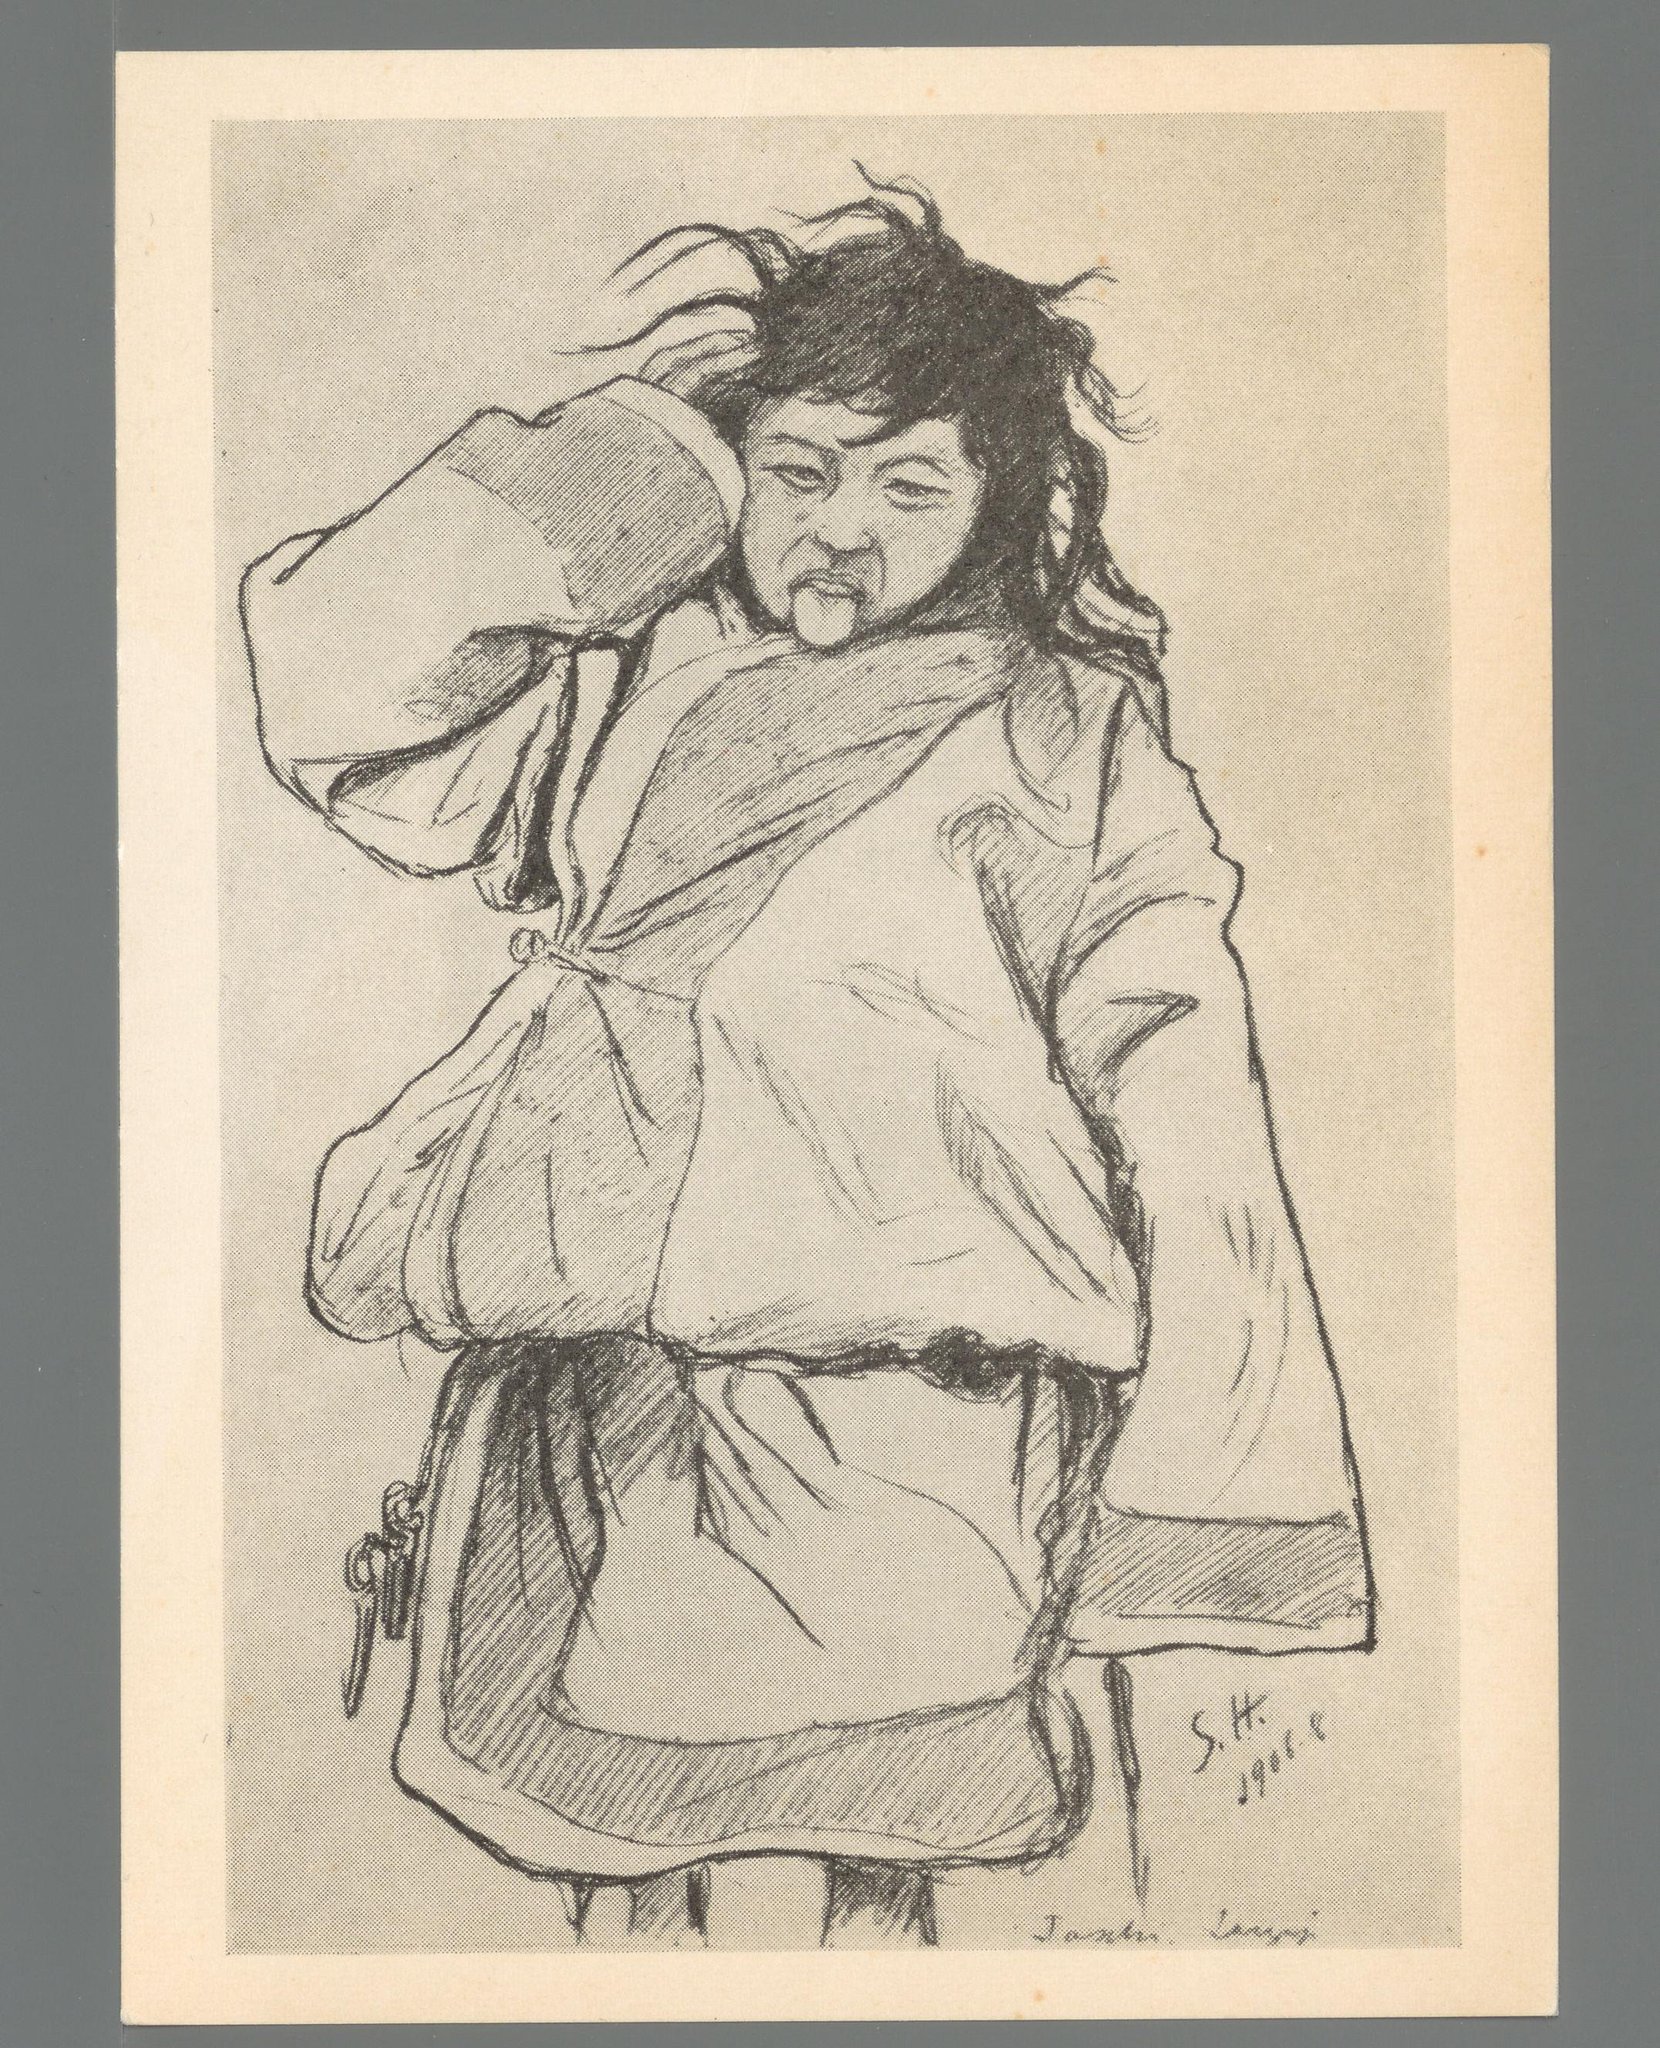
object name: ansichtkaart, prentbriefkaart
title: Tibetaanse jongen groet door zijn tong uit te steken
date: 1952-1979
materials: cardboard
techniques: autotype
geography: stockholm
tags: youth, adolescent, folk costume, regional costume, tongue stuck out